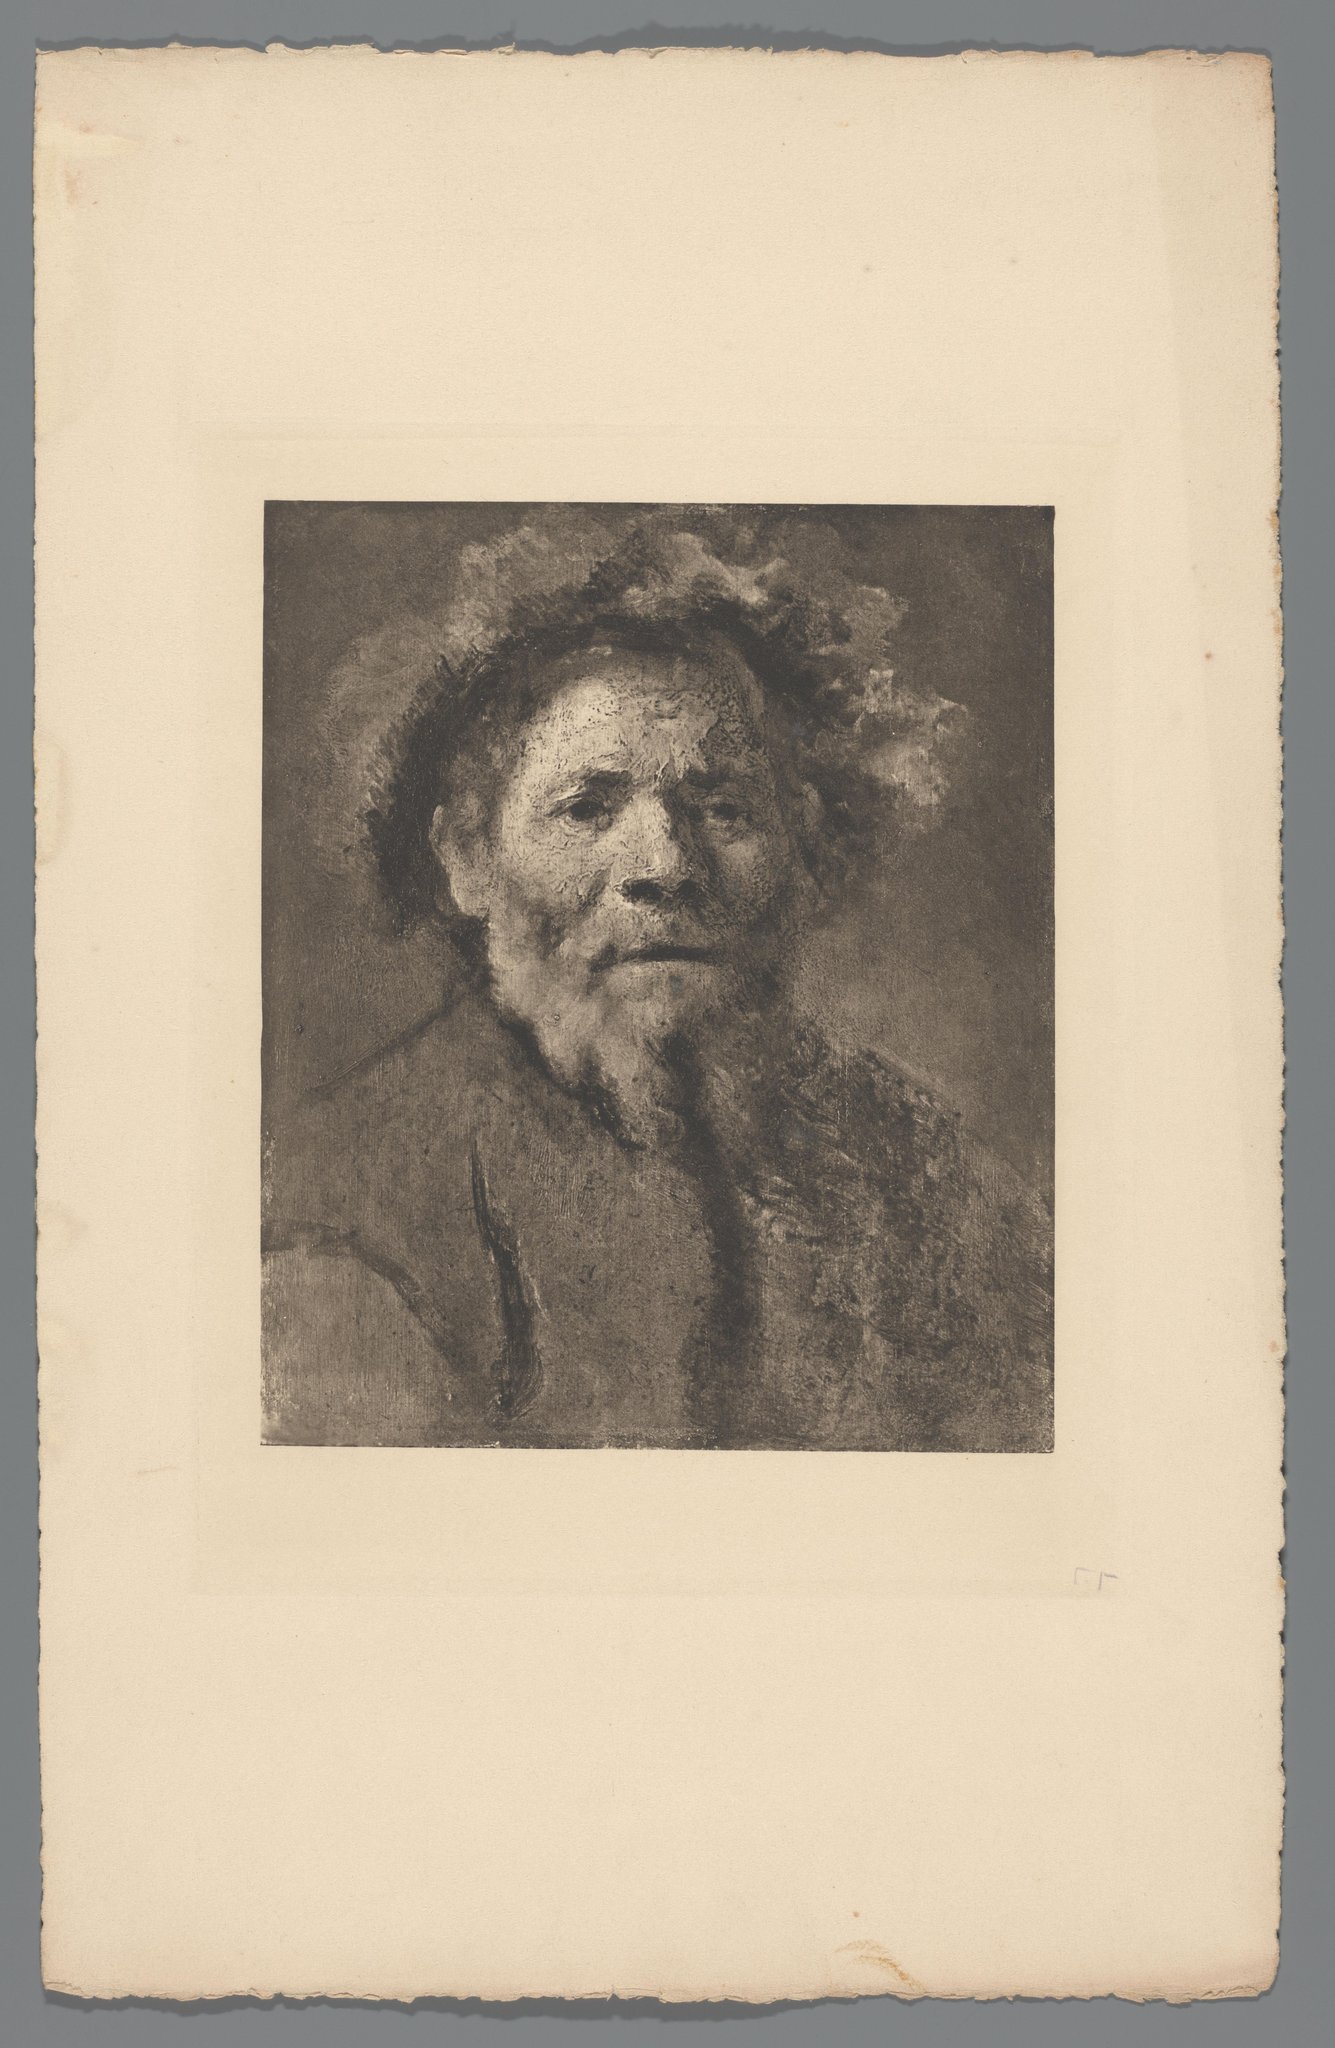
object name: photomechanical print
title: Reproductie van het schilderij Studie van een oude man door Rembrandt van Rijn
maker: Anonymous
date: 1880-2023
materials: paper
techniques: photoaquatint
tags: head-gear, anonymous historical person portrayed alone, old man